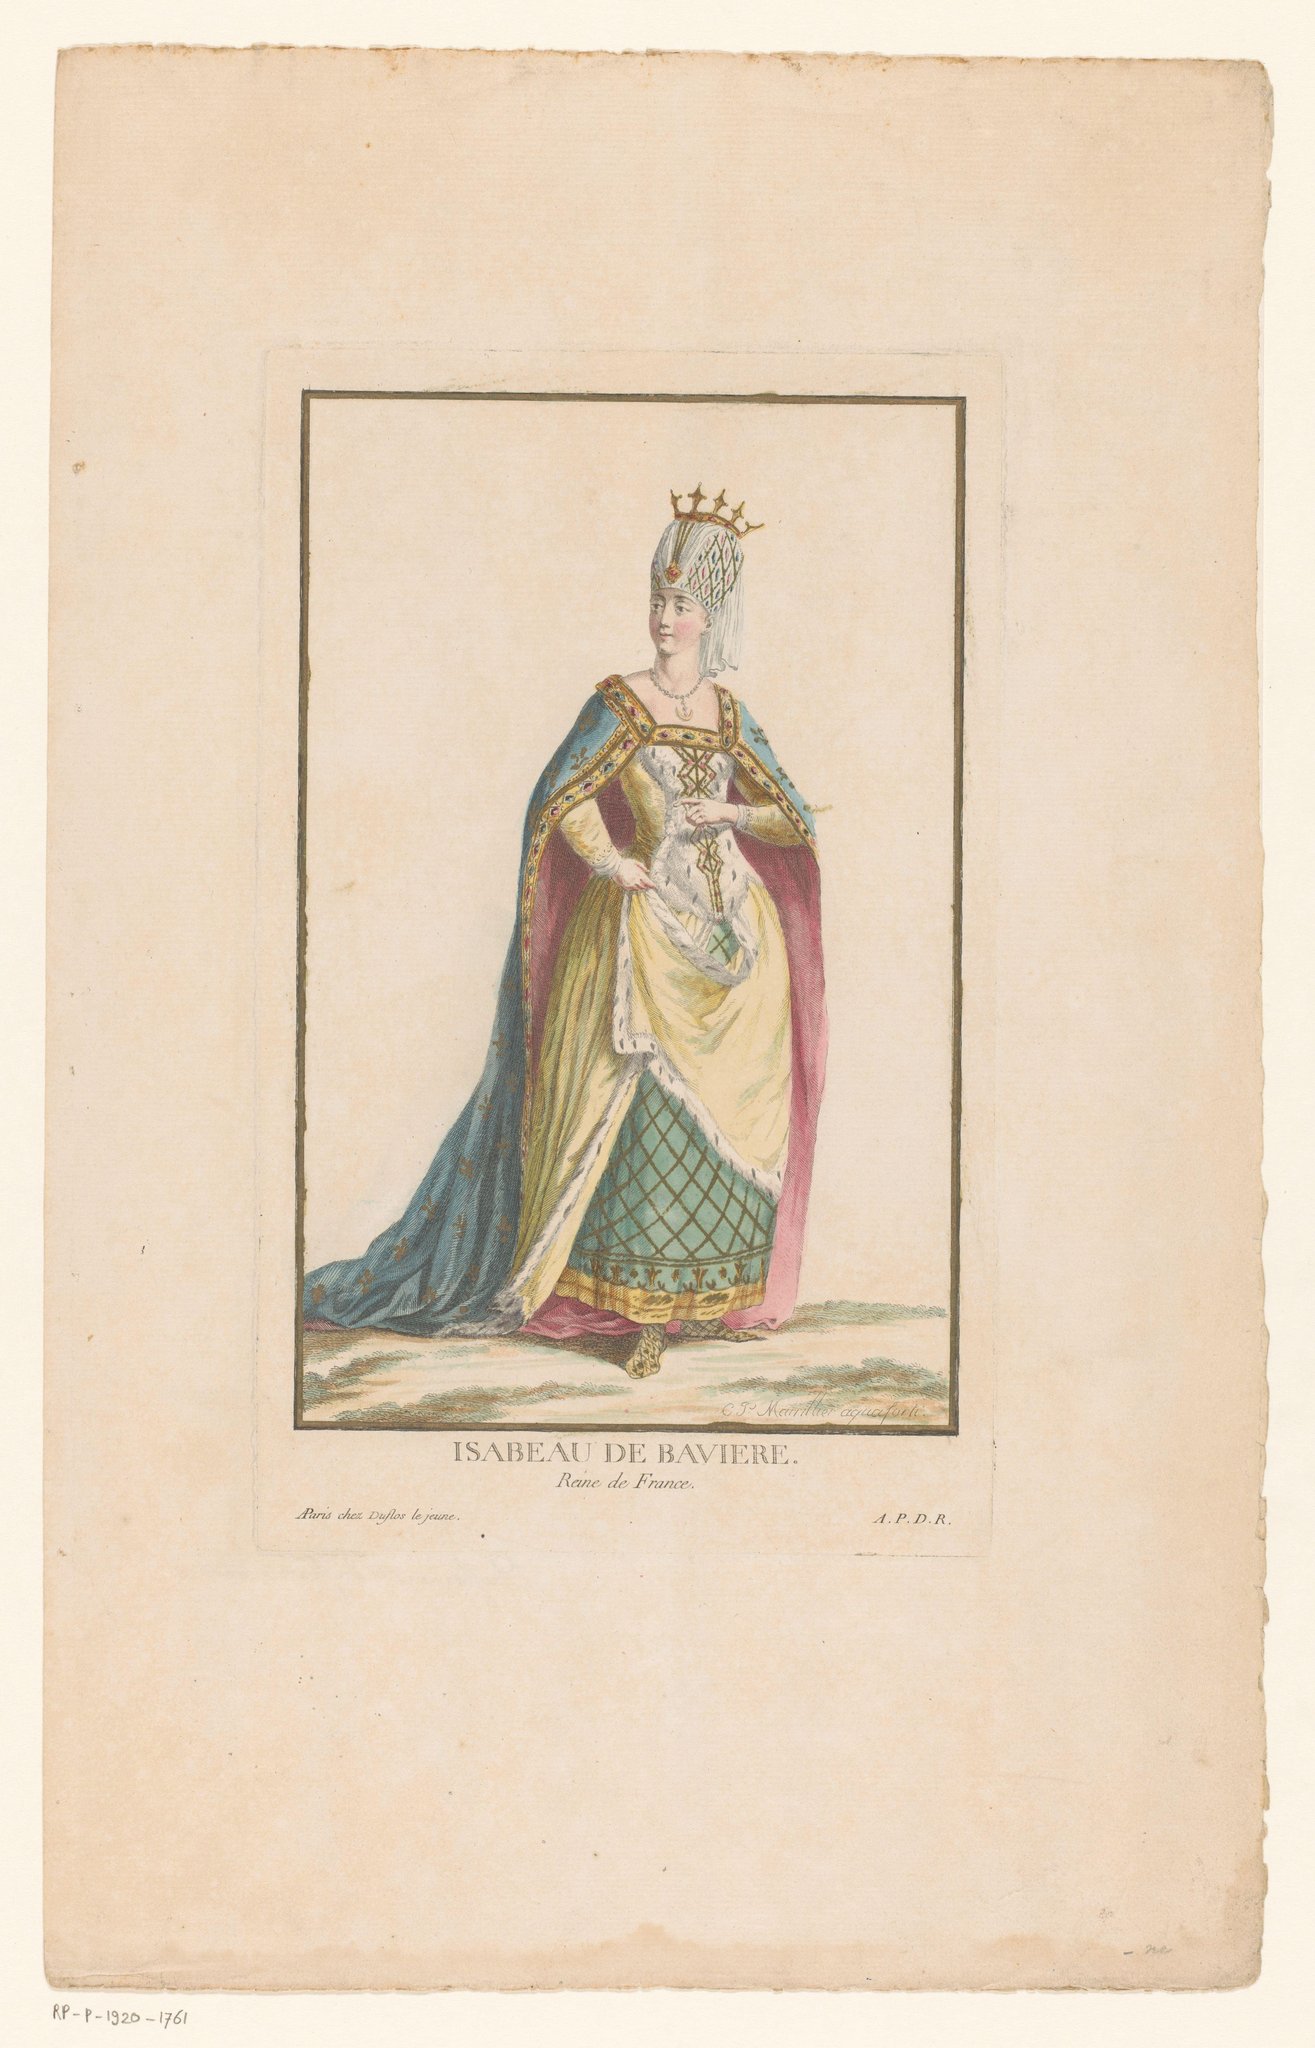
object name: print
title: Portret van Isabella van Beieren, koningin van Frankrijk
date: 1750-1808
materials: paper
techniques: etching, hand coloring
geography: paris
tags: paris, historical persons, queen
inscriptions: watermark, collector's mark: Lugt 2228, inscription: ‘Duflos M dufour (?) m[...]’